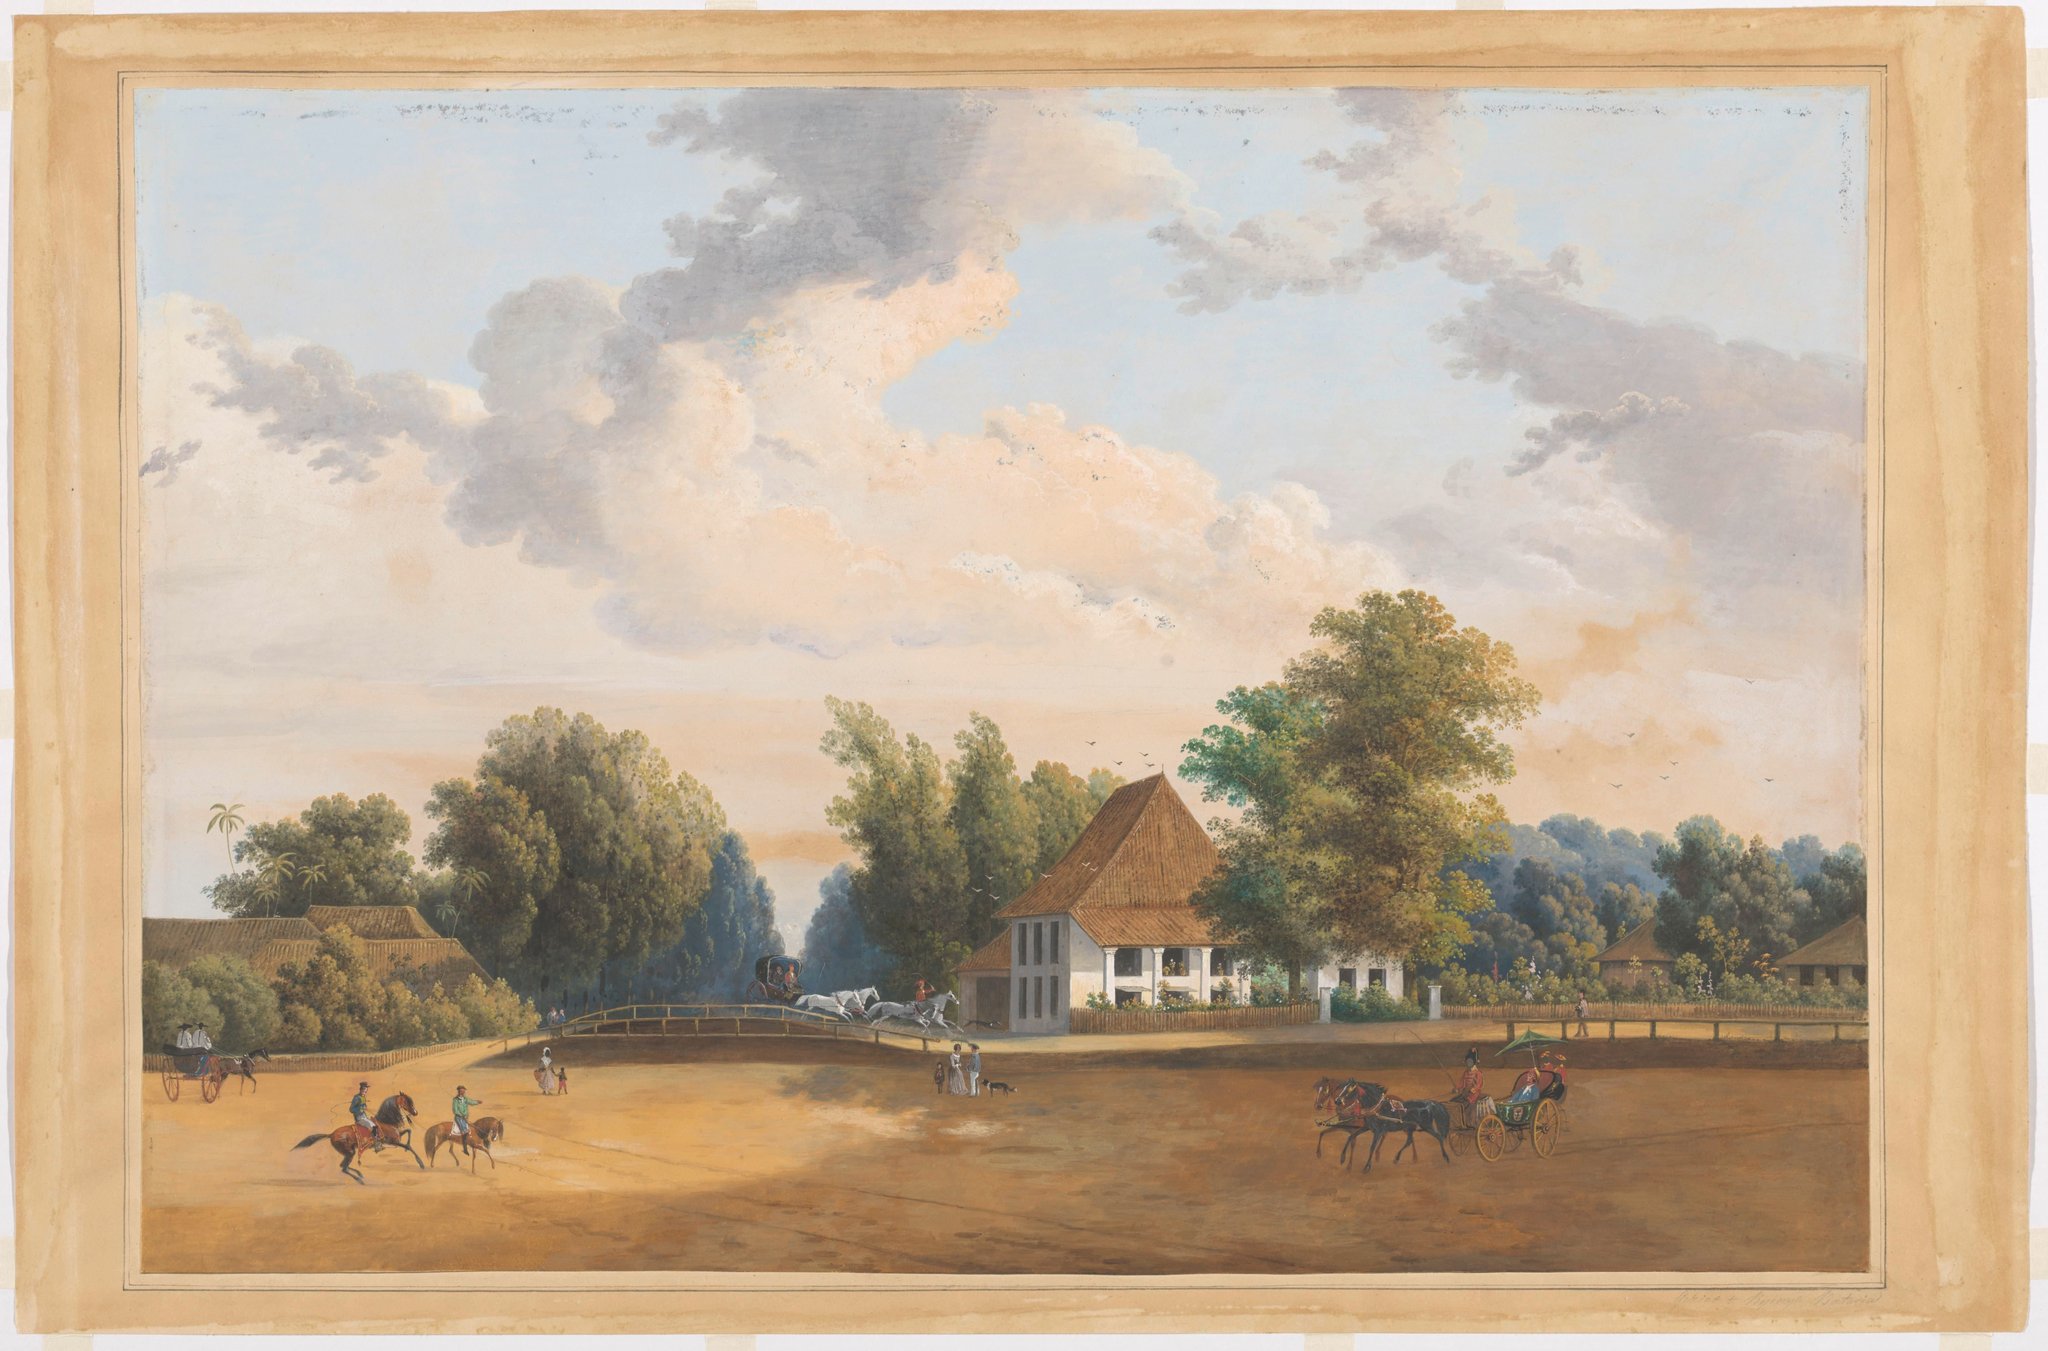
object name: watercolor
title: Gezicht te Rijswijk Batavia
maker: charles william meredith van de velde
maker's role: draughtsman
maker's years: 1818-1898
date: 1838-1898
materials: paint, gouache, paper, pencil, watercolor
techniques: brush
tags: batavia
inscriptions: inscription: ‘titel van werk in contemporain opschrift op passepartout in lijst’